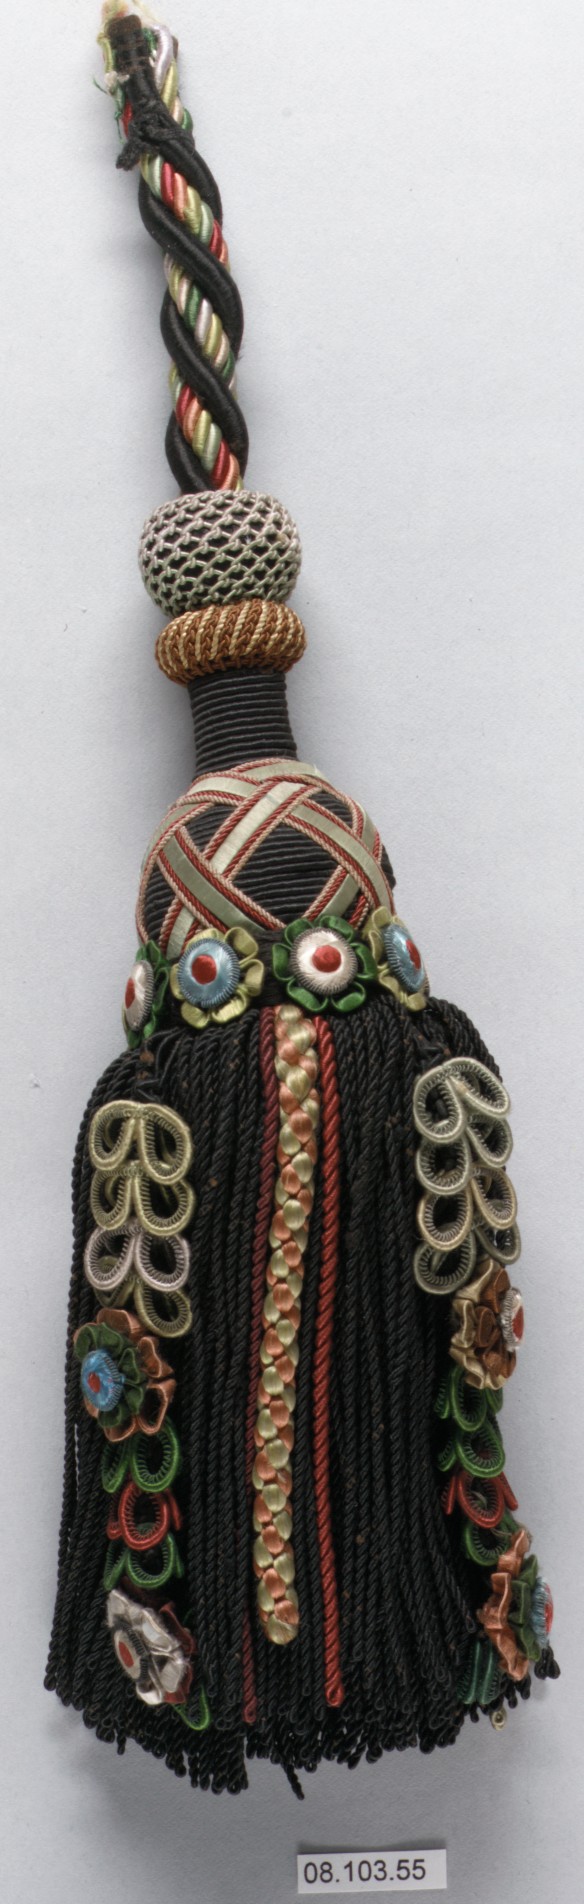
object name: tassel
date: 1801-1900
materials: cotton, silk